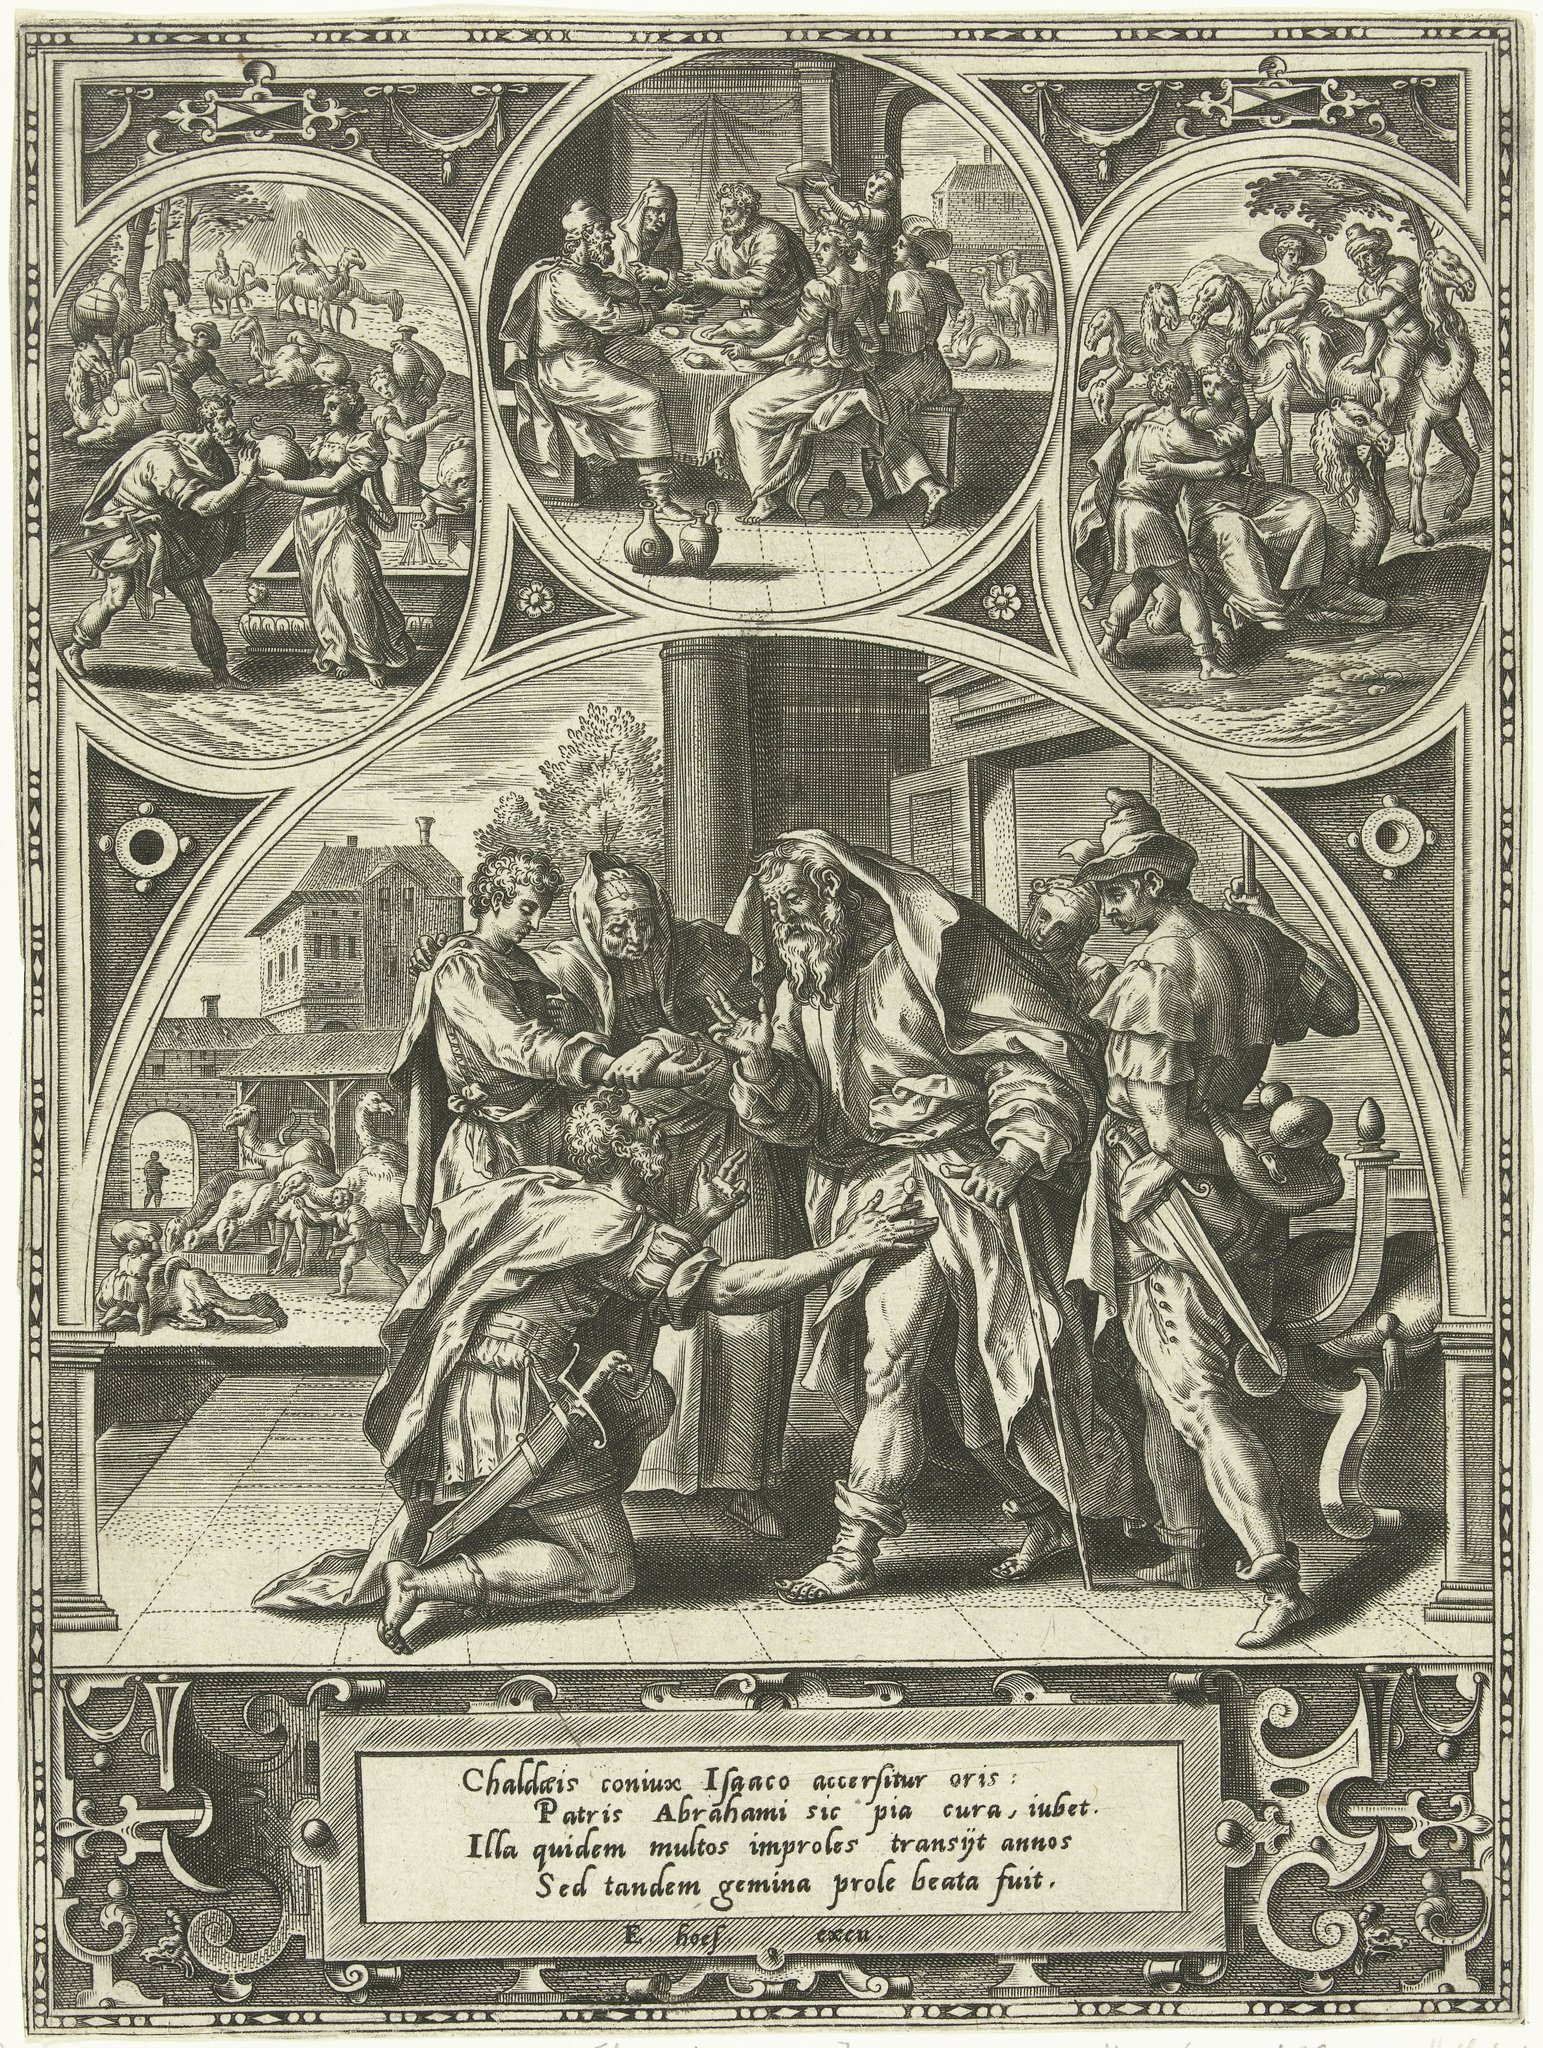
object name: print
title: Scènes uit Genesis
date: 1579-1583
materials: paper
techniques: engraving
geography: antwerp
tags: the meeting at the well: eliezer sees rebekah coming with a pitcher, isaac, walking in the fields, meets rebekah, eliezer is entertained by rebekah's parents, eliezer taking the oath: abraham sends him to his relatives in mesopotamia to find a wife for isaac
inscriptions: collector's mark: Lugt 240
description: Abraham stuurt zijn knecht Eliëzer de wereld in om op zoek te gaan naar een vrouw voor Isaak. Eliëzer zweert op de lies van Abraham dat hij een vrouw voor Isaak zal vinden. Boven, drie medaillons met afbeeldingen van de reis van Eliëzer: links de ontmoeting met Rebekka bij de waterput, midden Eliëzer tijdens het feestmaal gegeven door de broer van Rebekka, rechts de eerste ontmoeting tussen Rebekka en Isaak. De prent heeft een Latijns onderschrift in een cartouche. De prent is deel van een serie met scènes uit het Bijbelboek Genesis.